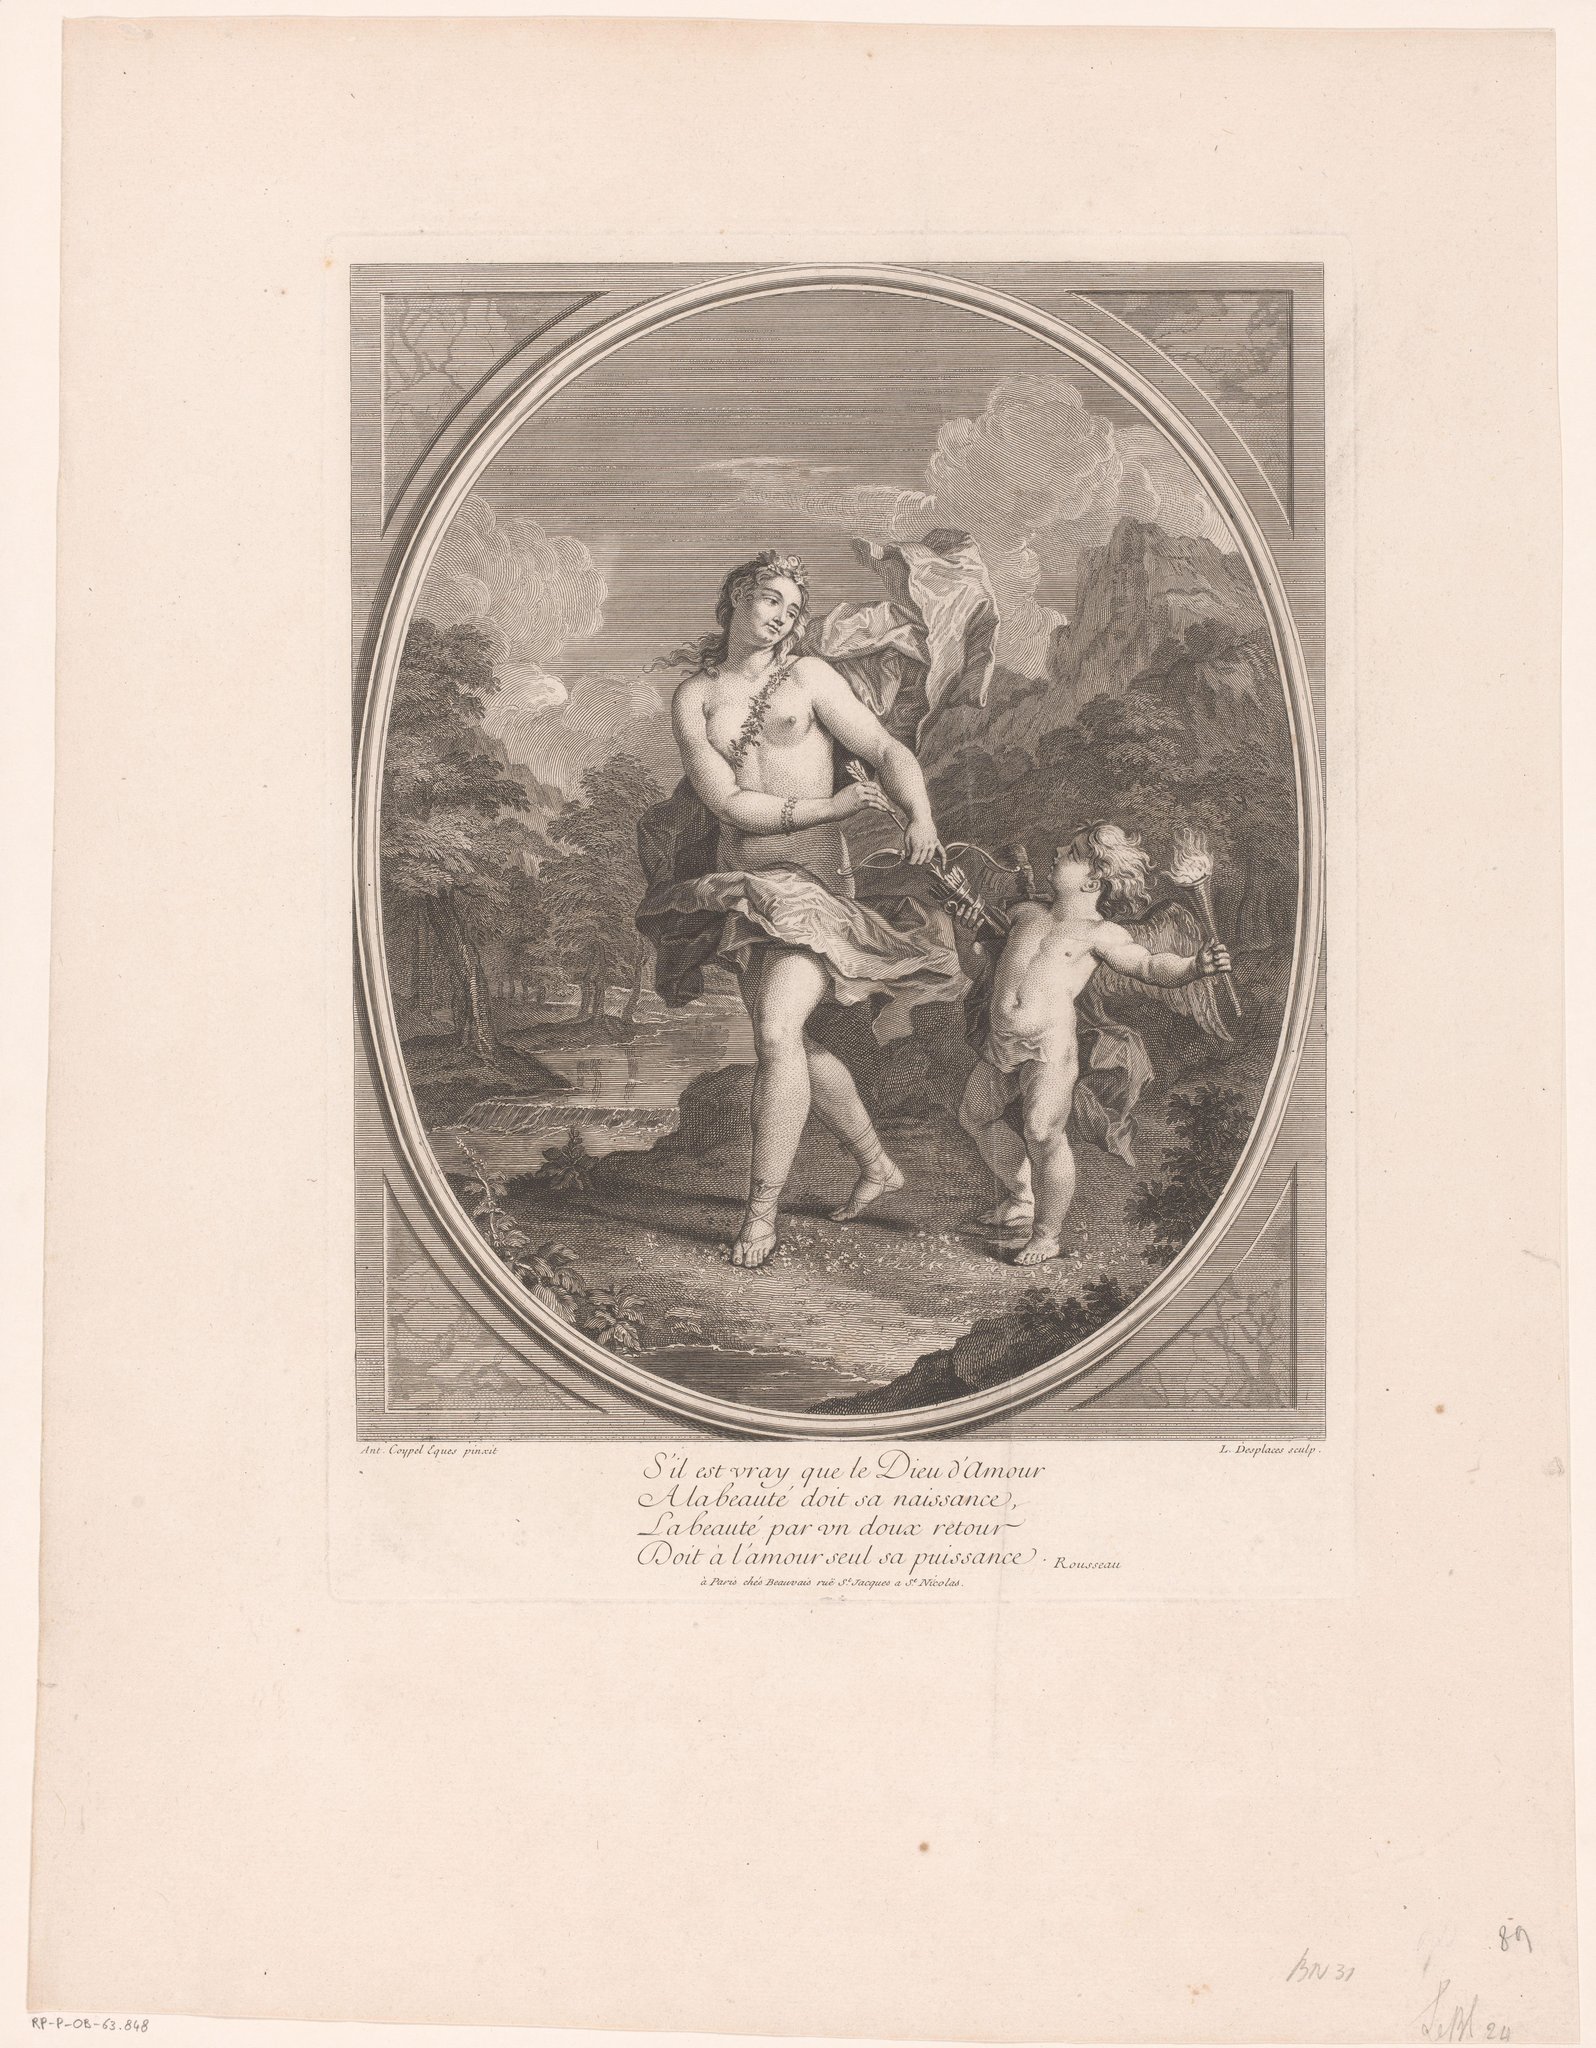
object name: print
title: Venus neemt een pijl van Amor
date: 1697-1739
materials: paper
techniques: engraving, etching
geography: paris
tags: venus and cupid (cupid not being mere attribute)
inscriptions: collector's mark: Lugt 2228